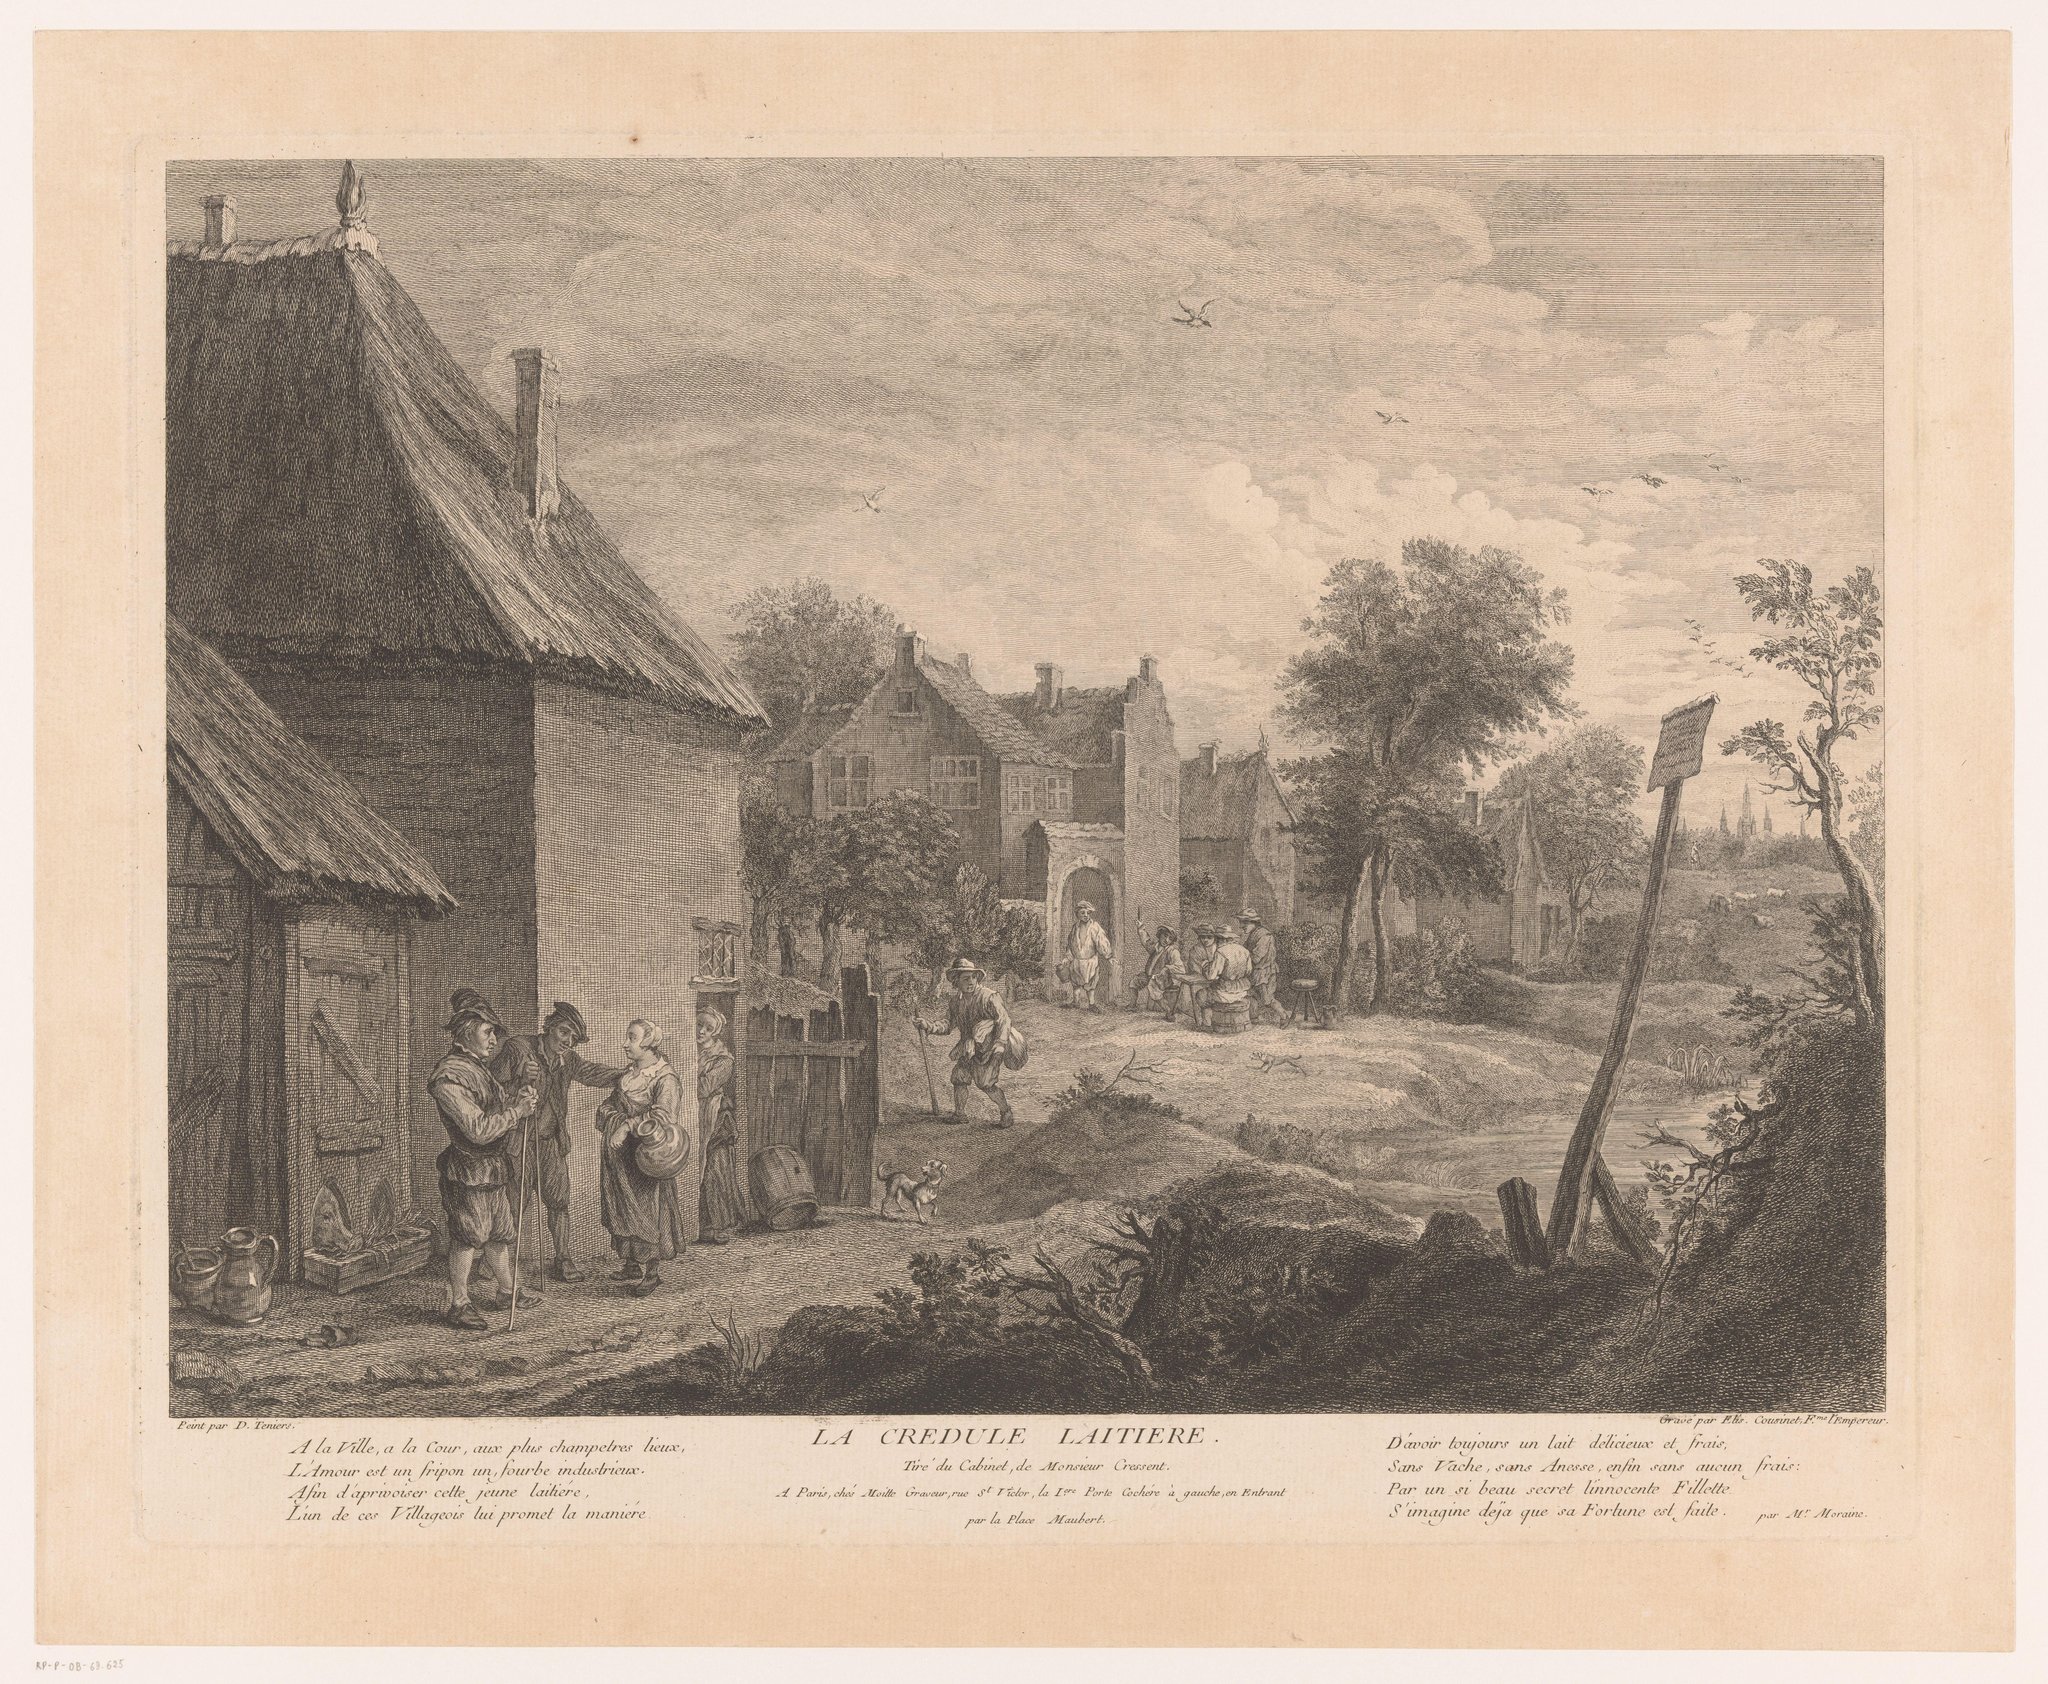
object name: print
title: Gezicht op een dorp met inwoners bij een melkmeid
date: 1762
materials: paper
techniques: engraving, etching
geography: france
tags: village, milkmaid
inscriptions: collector's mark: Lugt 2228